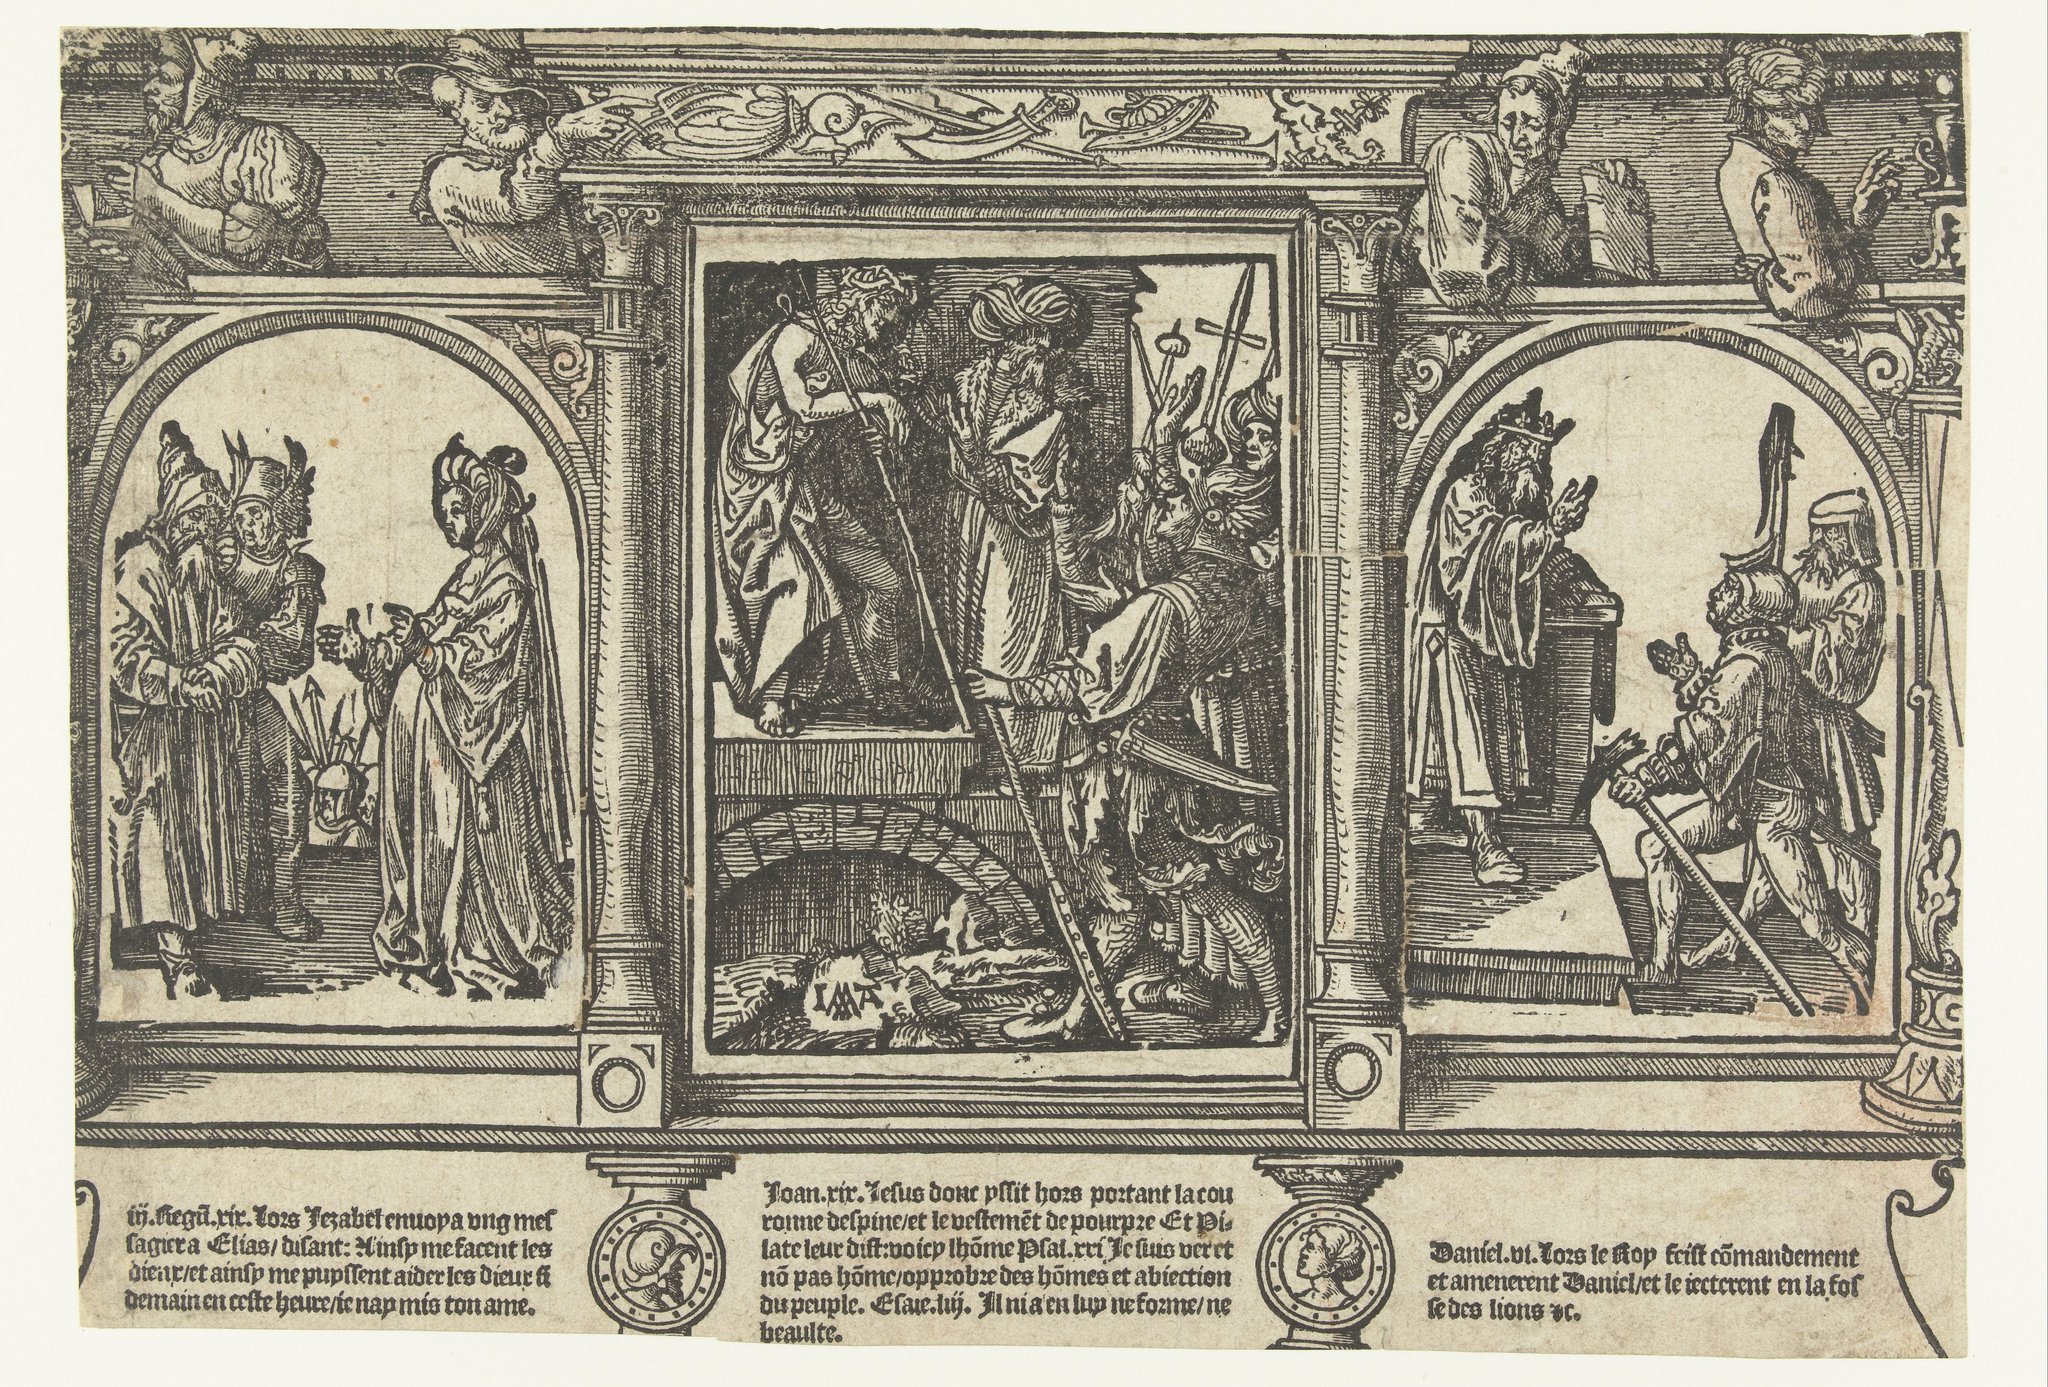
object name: print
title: Pilatus toont Christus aan het volk (Ecce Homo), Izabel bedreigt Elia en de Babyloniërs eisen Daniëls dood.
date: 1520-1521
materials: paper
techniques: woodcut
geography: low countries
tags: other groups of prophets, daniel and king darius (daniel 6), jezebel sends a message to elijah in which she threatens to take his life, pilate showing christ to the people, 'ostentatio christi', 'ecce homo' (john 19:4-6)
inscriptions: collector's mark: Lugt 240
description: Bovenste deel van en blad uit een Biblia Pauperum. Links Izabel bedreigt Eilas met de dood, in het midden Pilatus toont Christus aan het volk, rechts de Babyloniërs eisen Daniëls dood. Omlijsting met vier profeten. Tekst in het Frans onder de voorstellingen.